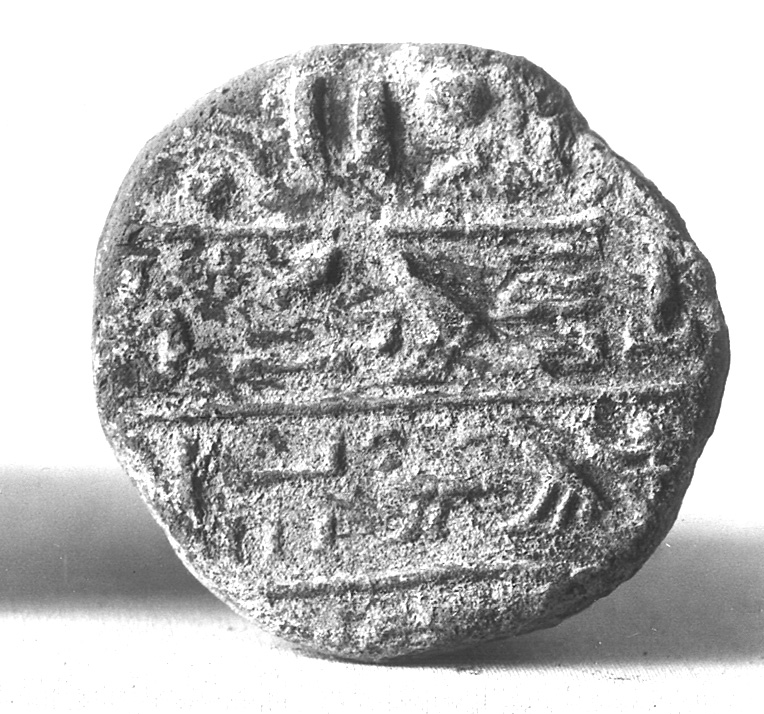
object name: cone, circular impression, simut, deputy, medjay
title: Funerary Cone of the Deputy of the Medjay Simut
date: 1550-1352 BCE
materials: pottery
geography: egypt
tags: hieroglyphs